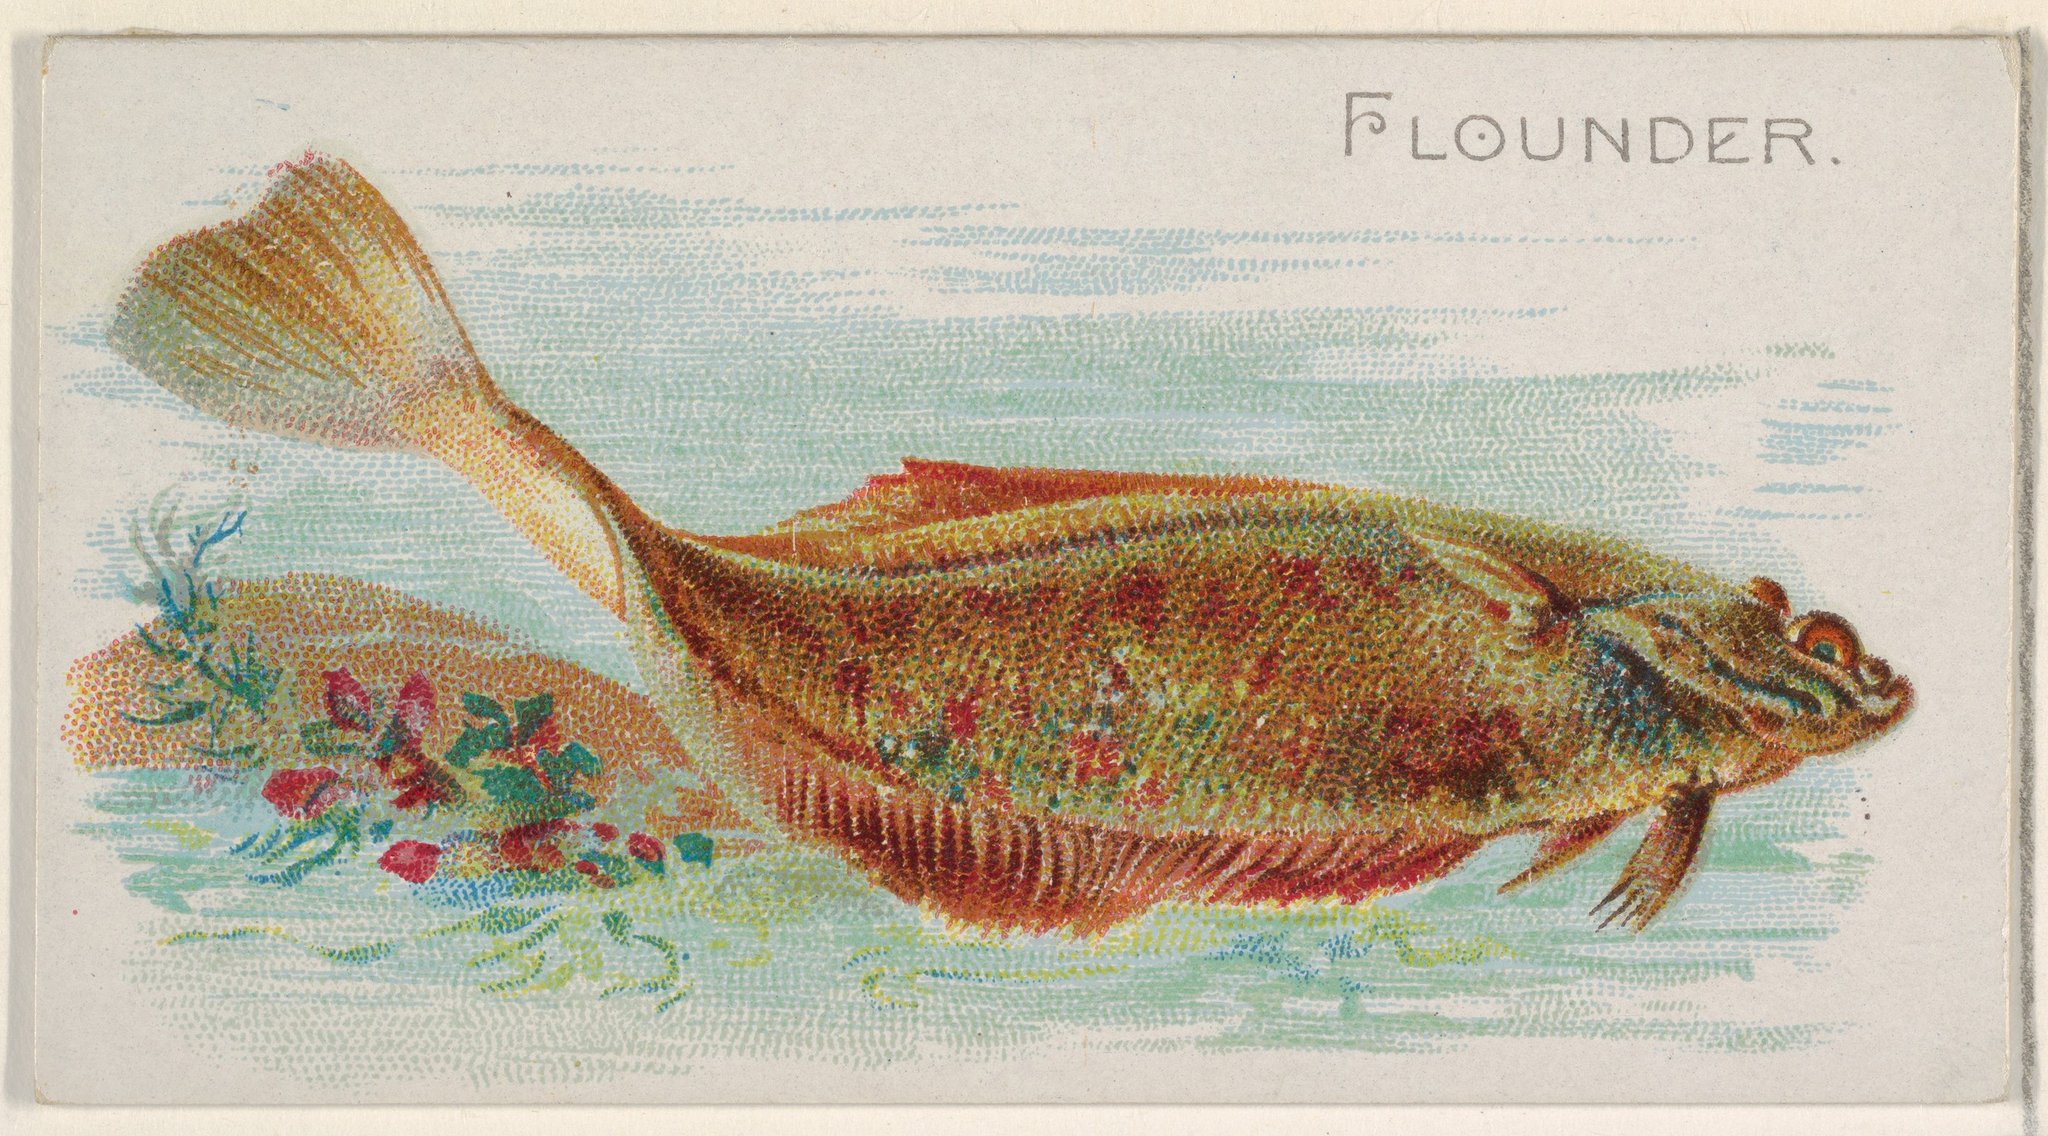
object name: print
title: Flounder, from the Fish from American Waters series (N8) for Allen & Ginter Cigarettes Brands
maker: allen & ginter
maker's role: publisher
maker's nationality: american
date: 1889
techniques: color lithograph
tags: fish